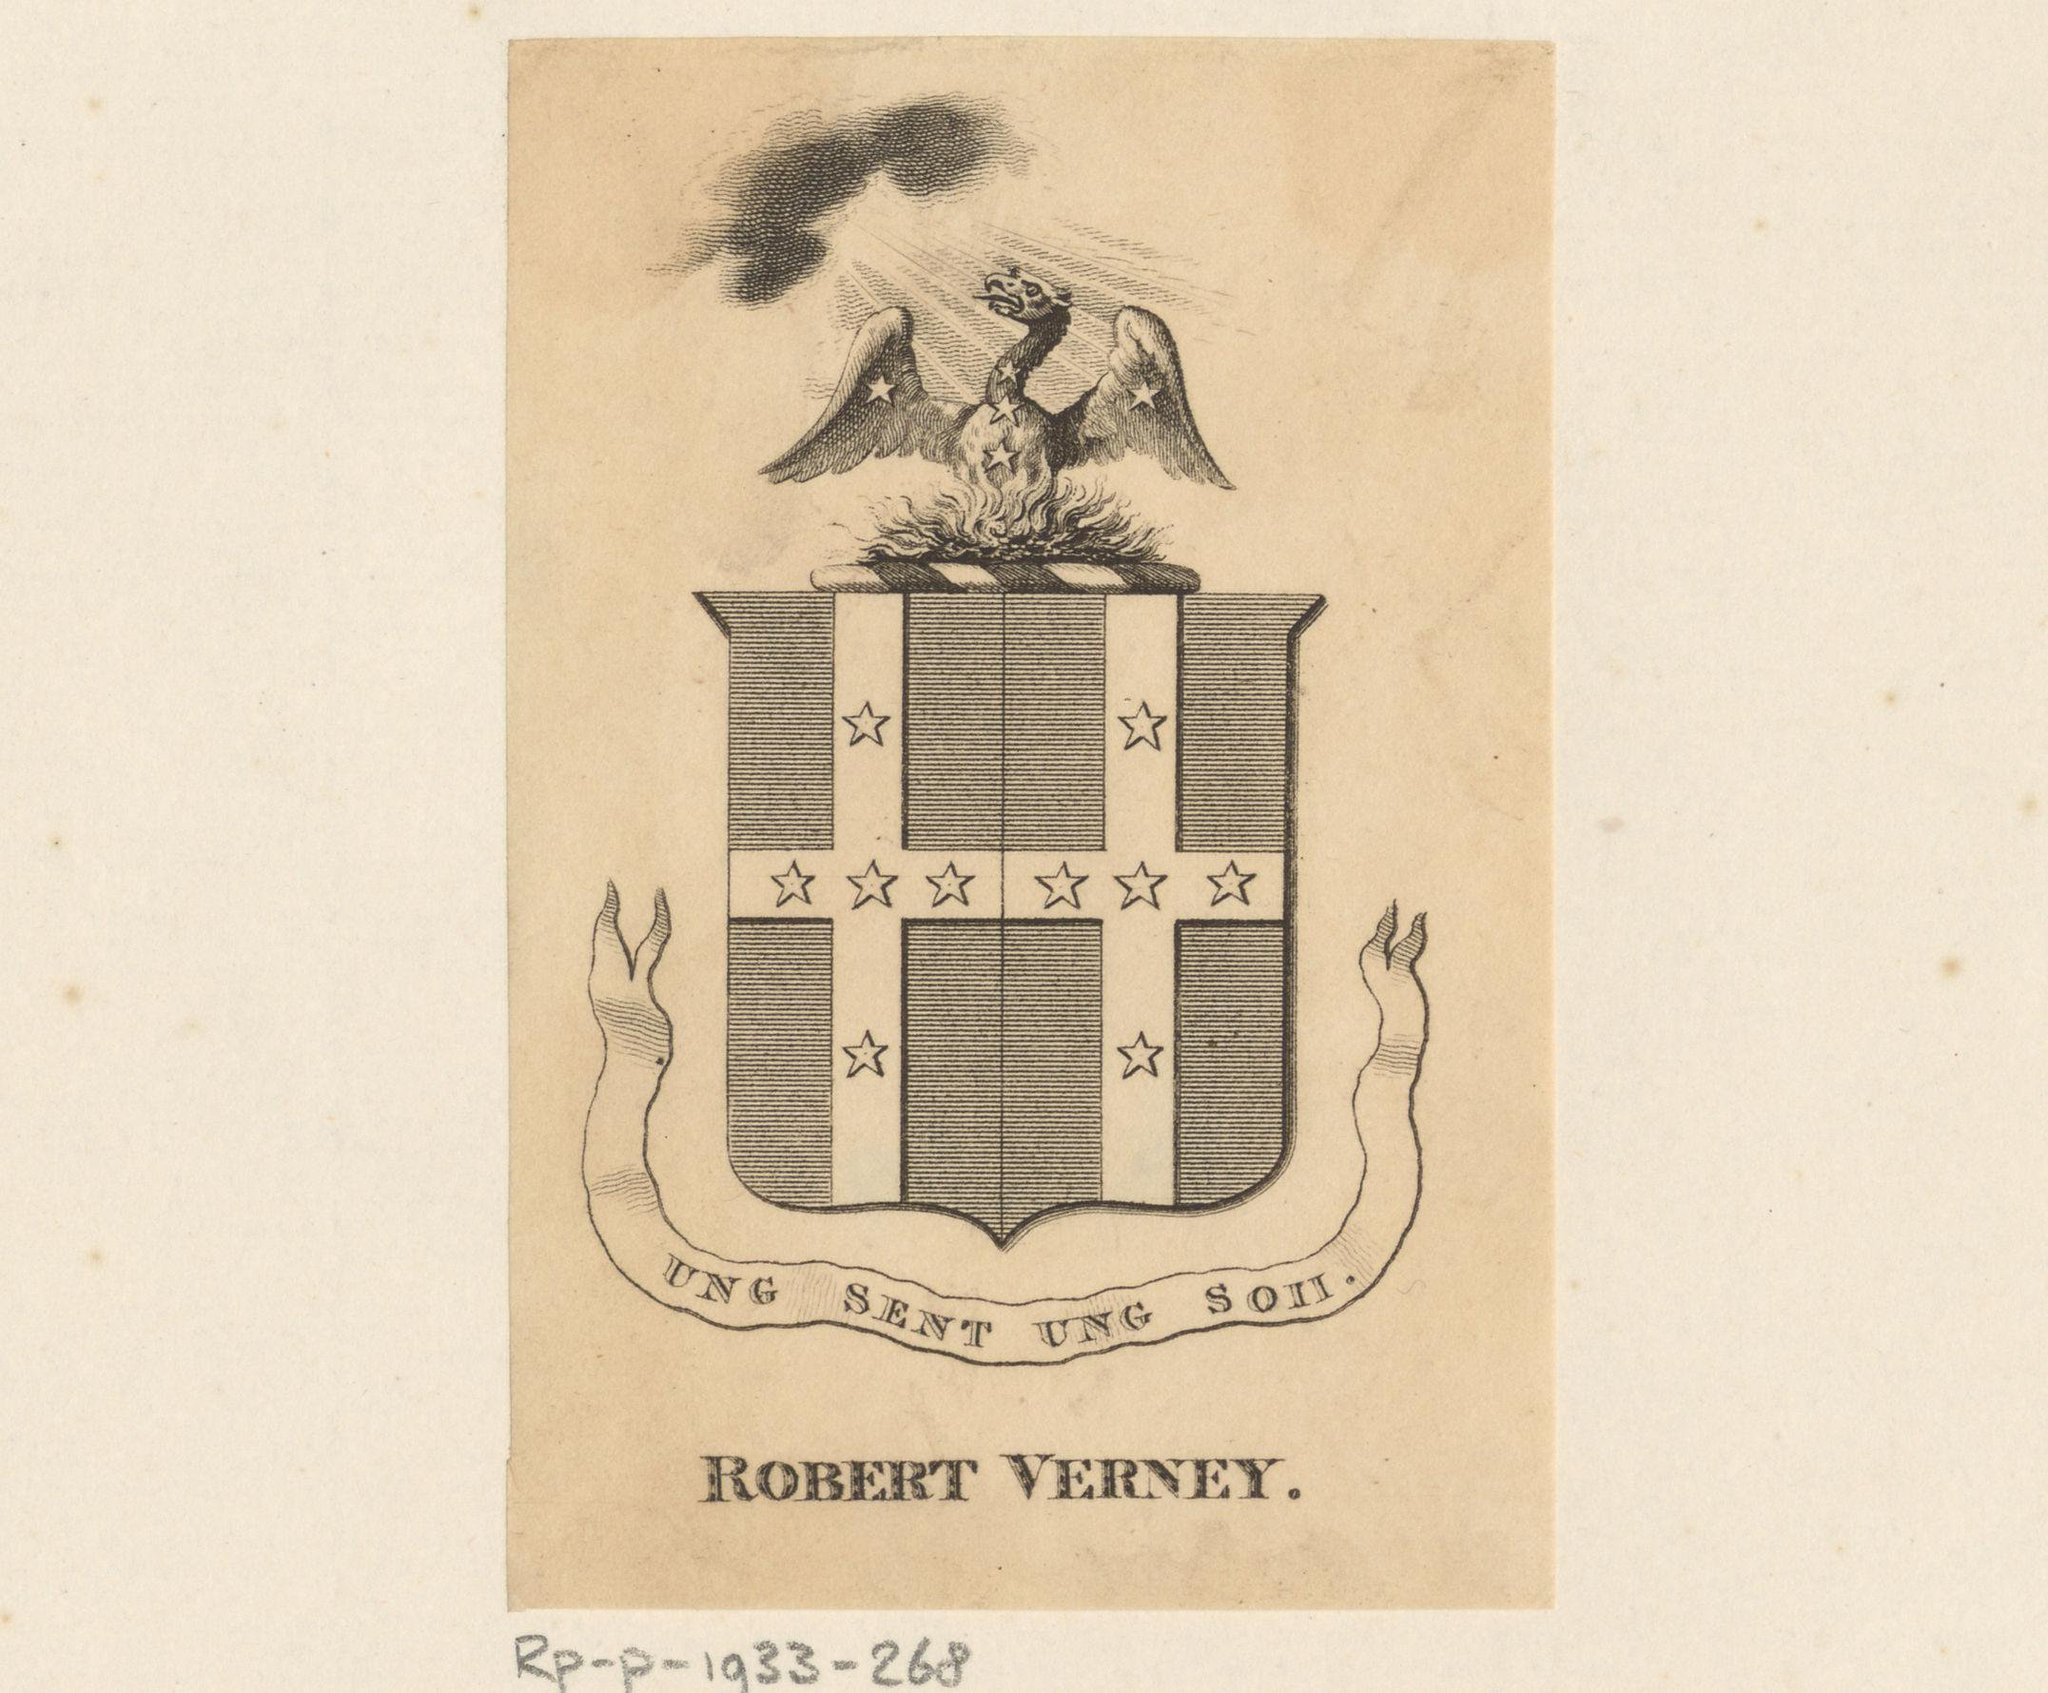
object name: bookplate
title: Ex libris van Robert Verney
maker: Anonymous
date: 1800-1899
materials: paper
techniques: etching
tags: armorial bearing, heraldry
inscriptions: collector's mark: Lugt 2760